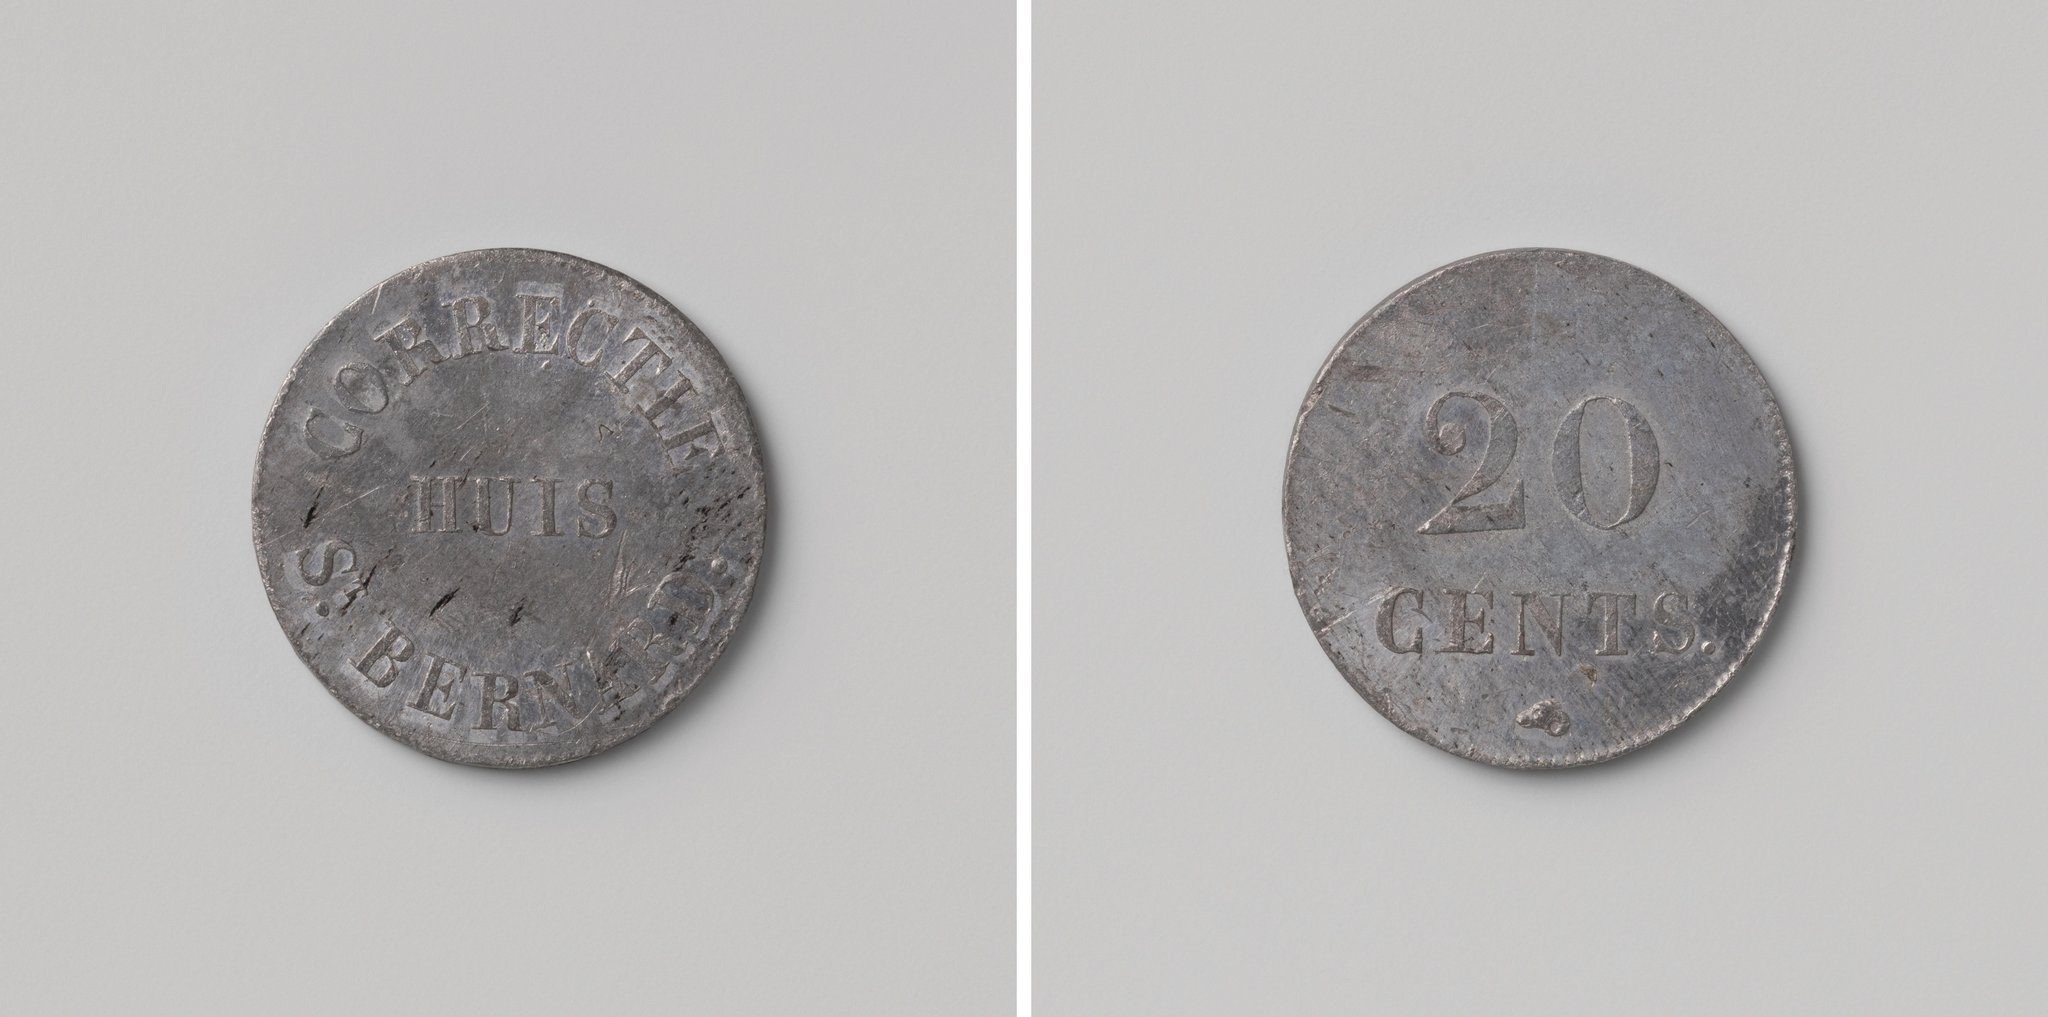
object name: twintig cent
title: Correctiehuis Sint Bernhard te Hemiksem, huismunt ter waarde van twintig cents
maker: joseph pierre braemt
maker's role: print maker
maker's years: 1796-1864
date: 1826-1833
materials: zinc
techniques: striking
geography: brussels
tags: ghent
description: Zinken betaalpenning. Voorzijde: opschrift binnen omschrift. Keerzijde: waardeaanduiding